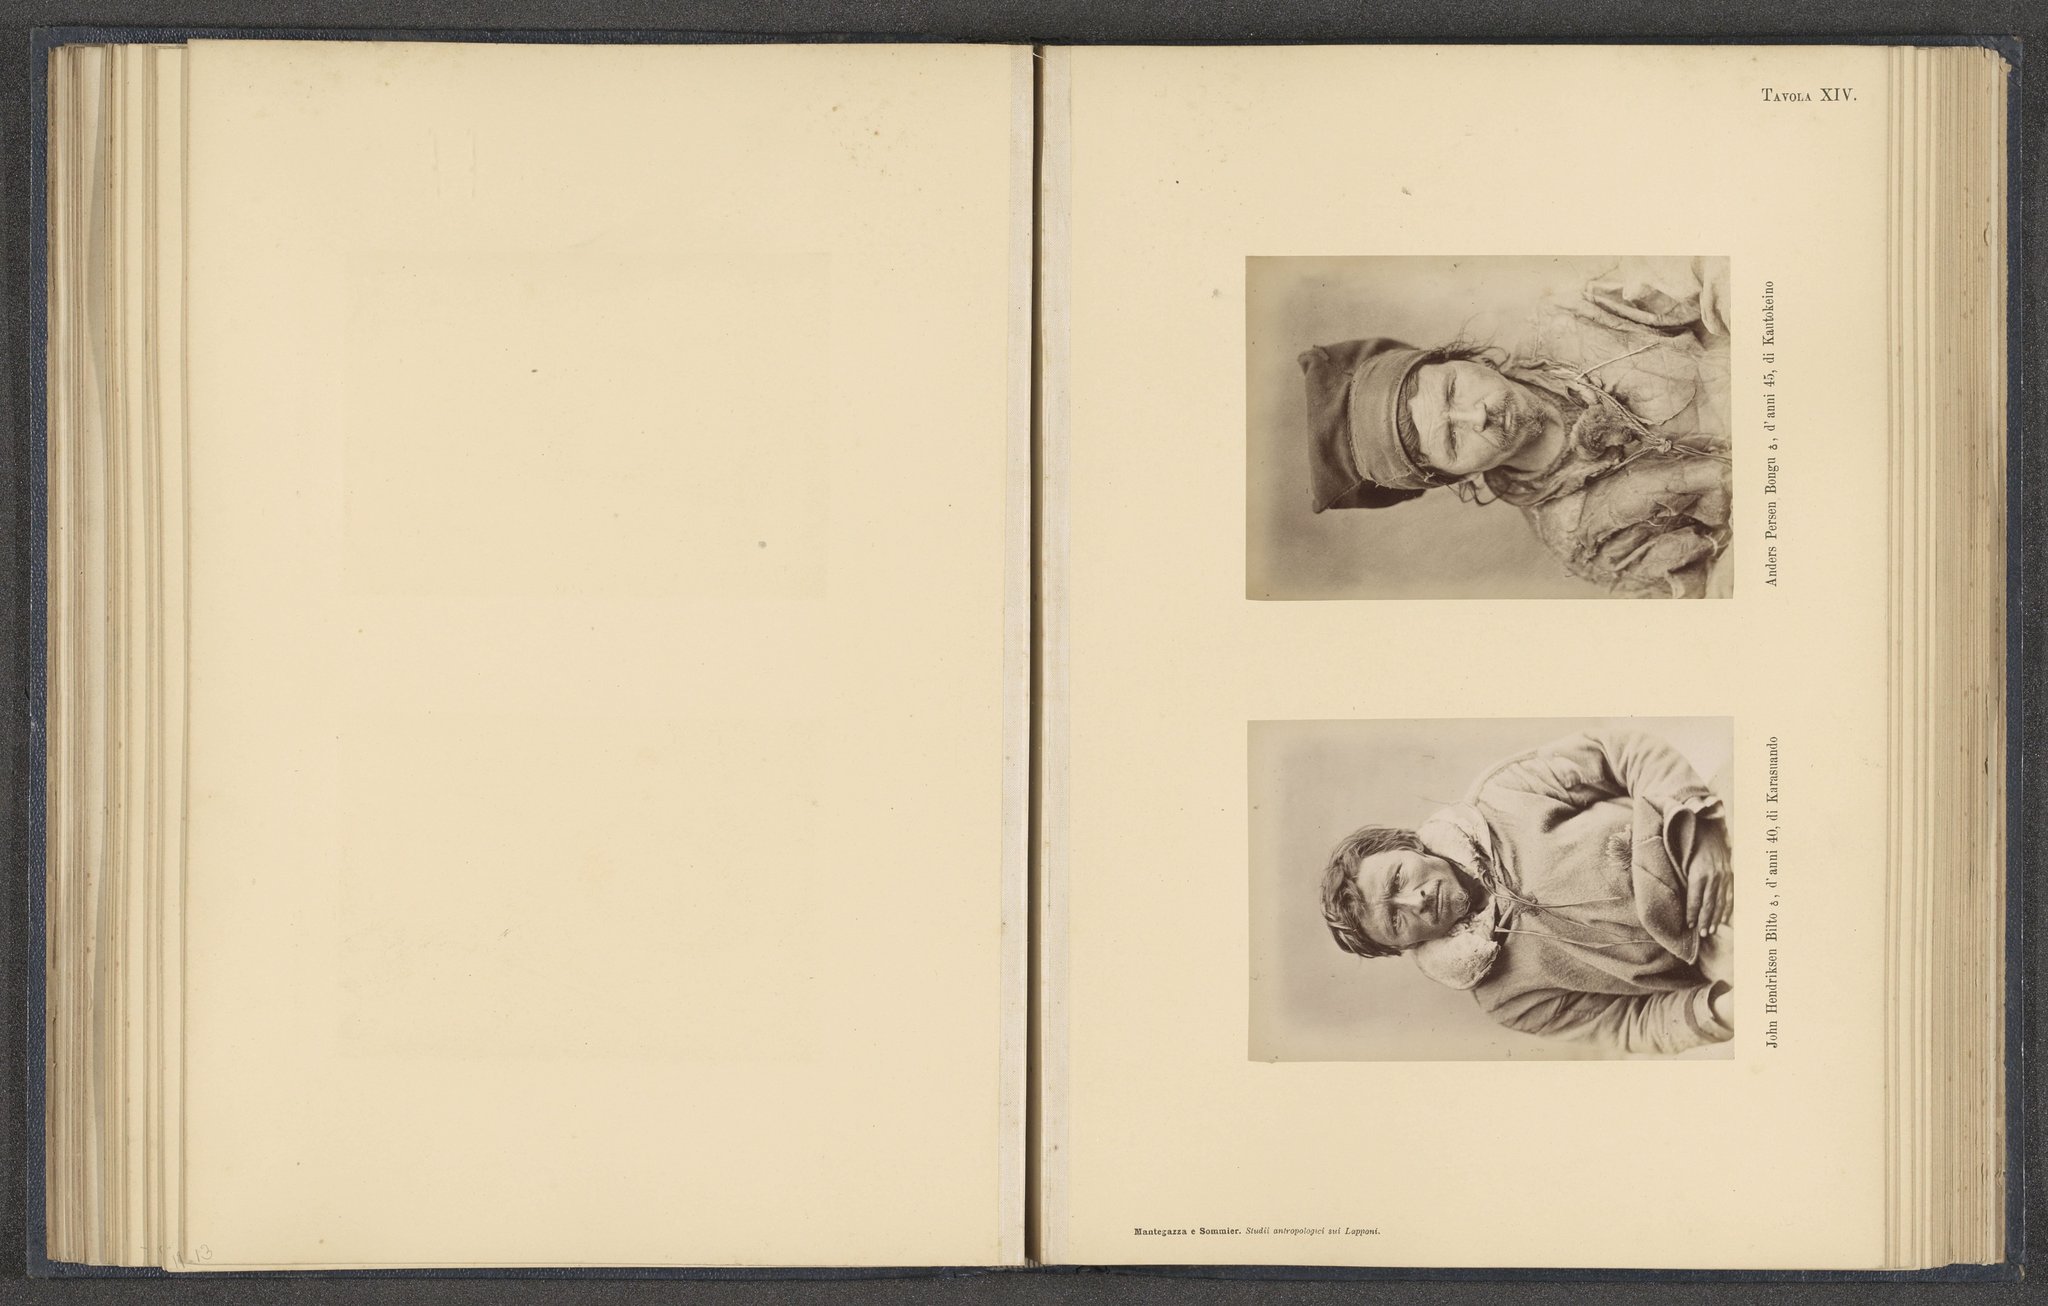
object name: page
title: John Hendriksen Bilto ♂, d' anni 40, di Karasuando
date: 1870-1880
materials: paper, photographic support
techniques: albumen print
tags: head-gear, adult man (+ front view), fashion, clothing (+ fur used for clothes)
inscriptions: number: ‘Tavola XIV.’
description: Links een vooraanzicht van John Hendriksen Bilto, rechts een vooraanzicht van Anders Persen Bongu.